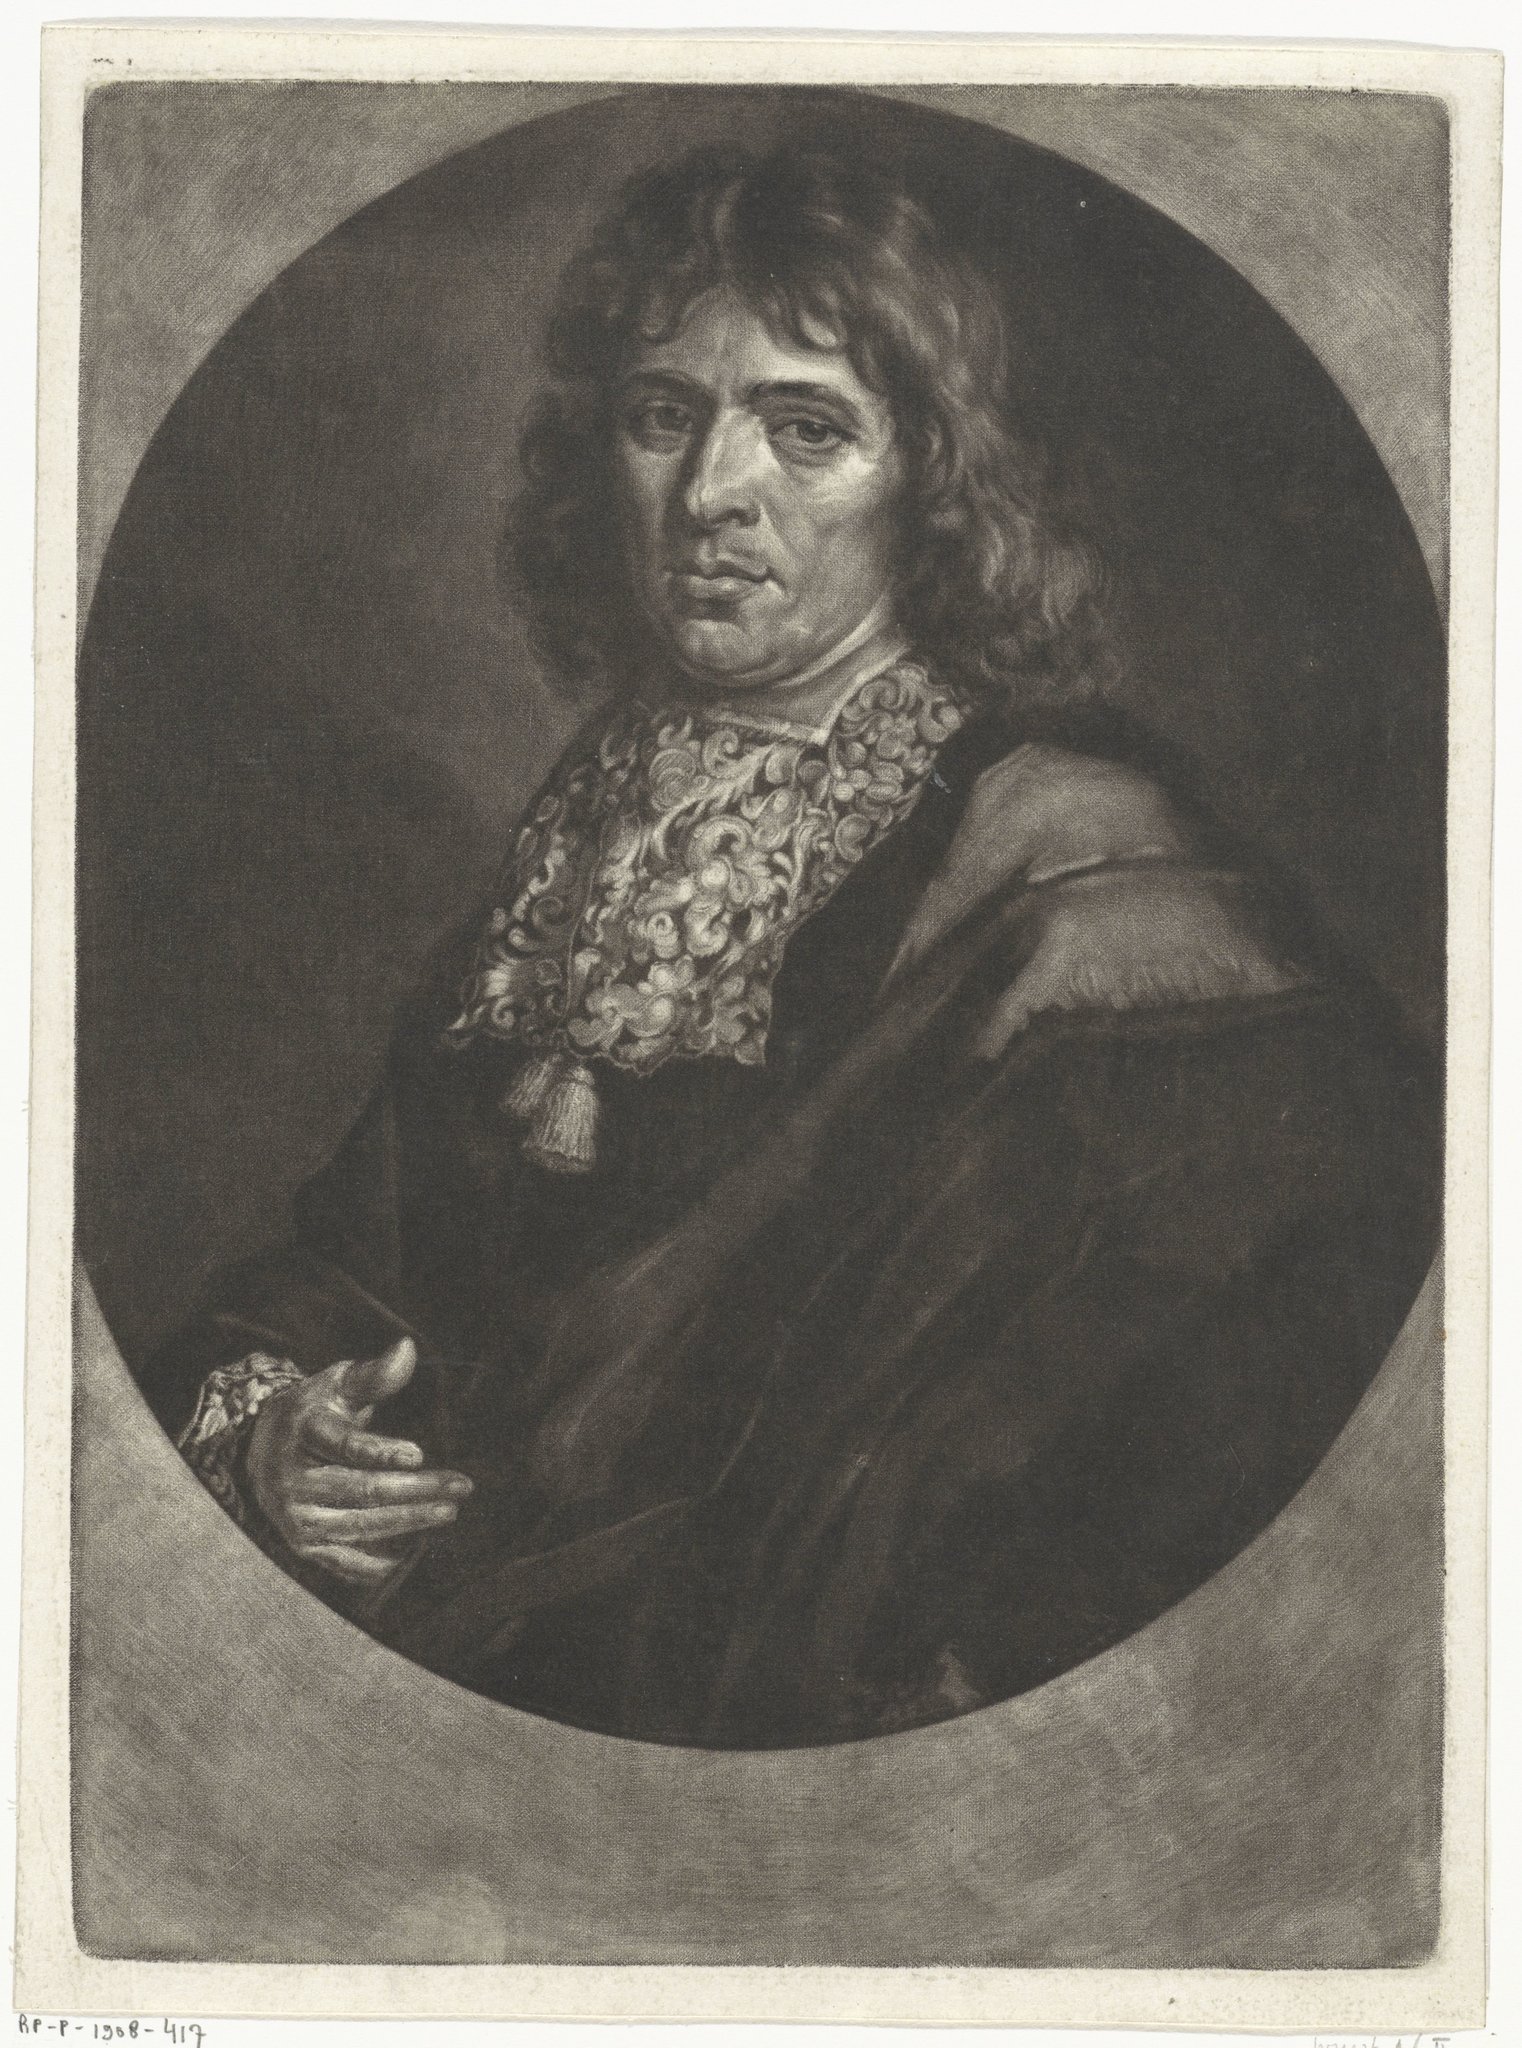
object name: print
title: Portret van Adriaan Dortsman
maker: pieter van der plas (ii)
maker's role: print maker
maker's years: 1647-1708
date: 1687-1708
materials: paper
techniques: mezzotint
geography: amsterdam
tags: flushing, amsterdam, draughtsman, adriaan dortsman, portrait, self-portrait of architect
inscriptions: collector's mark: Lugt 2228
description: De architect Adriaan Dortsman met een kraag van kant. Dortsman was verantwoordelijk voor het ontwerp van diverse bouwwerken in Amsterdam, waaronder de ronde Lutherse Kerk aan het Singel.